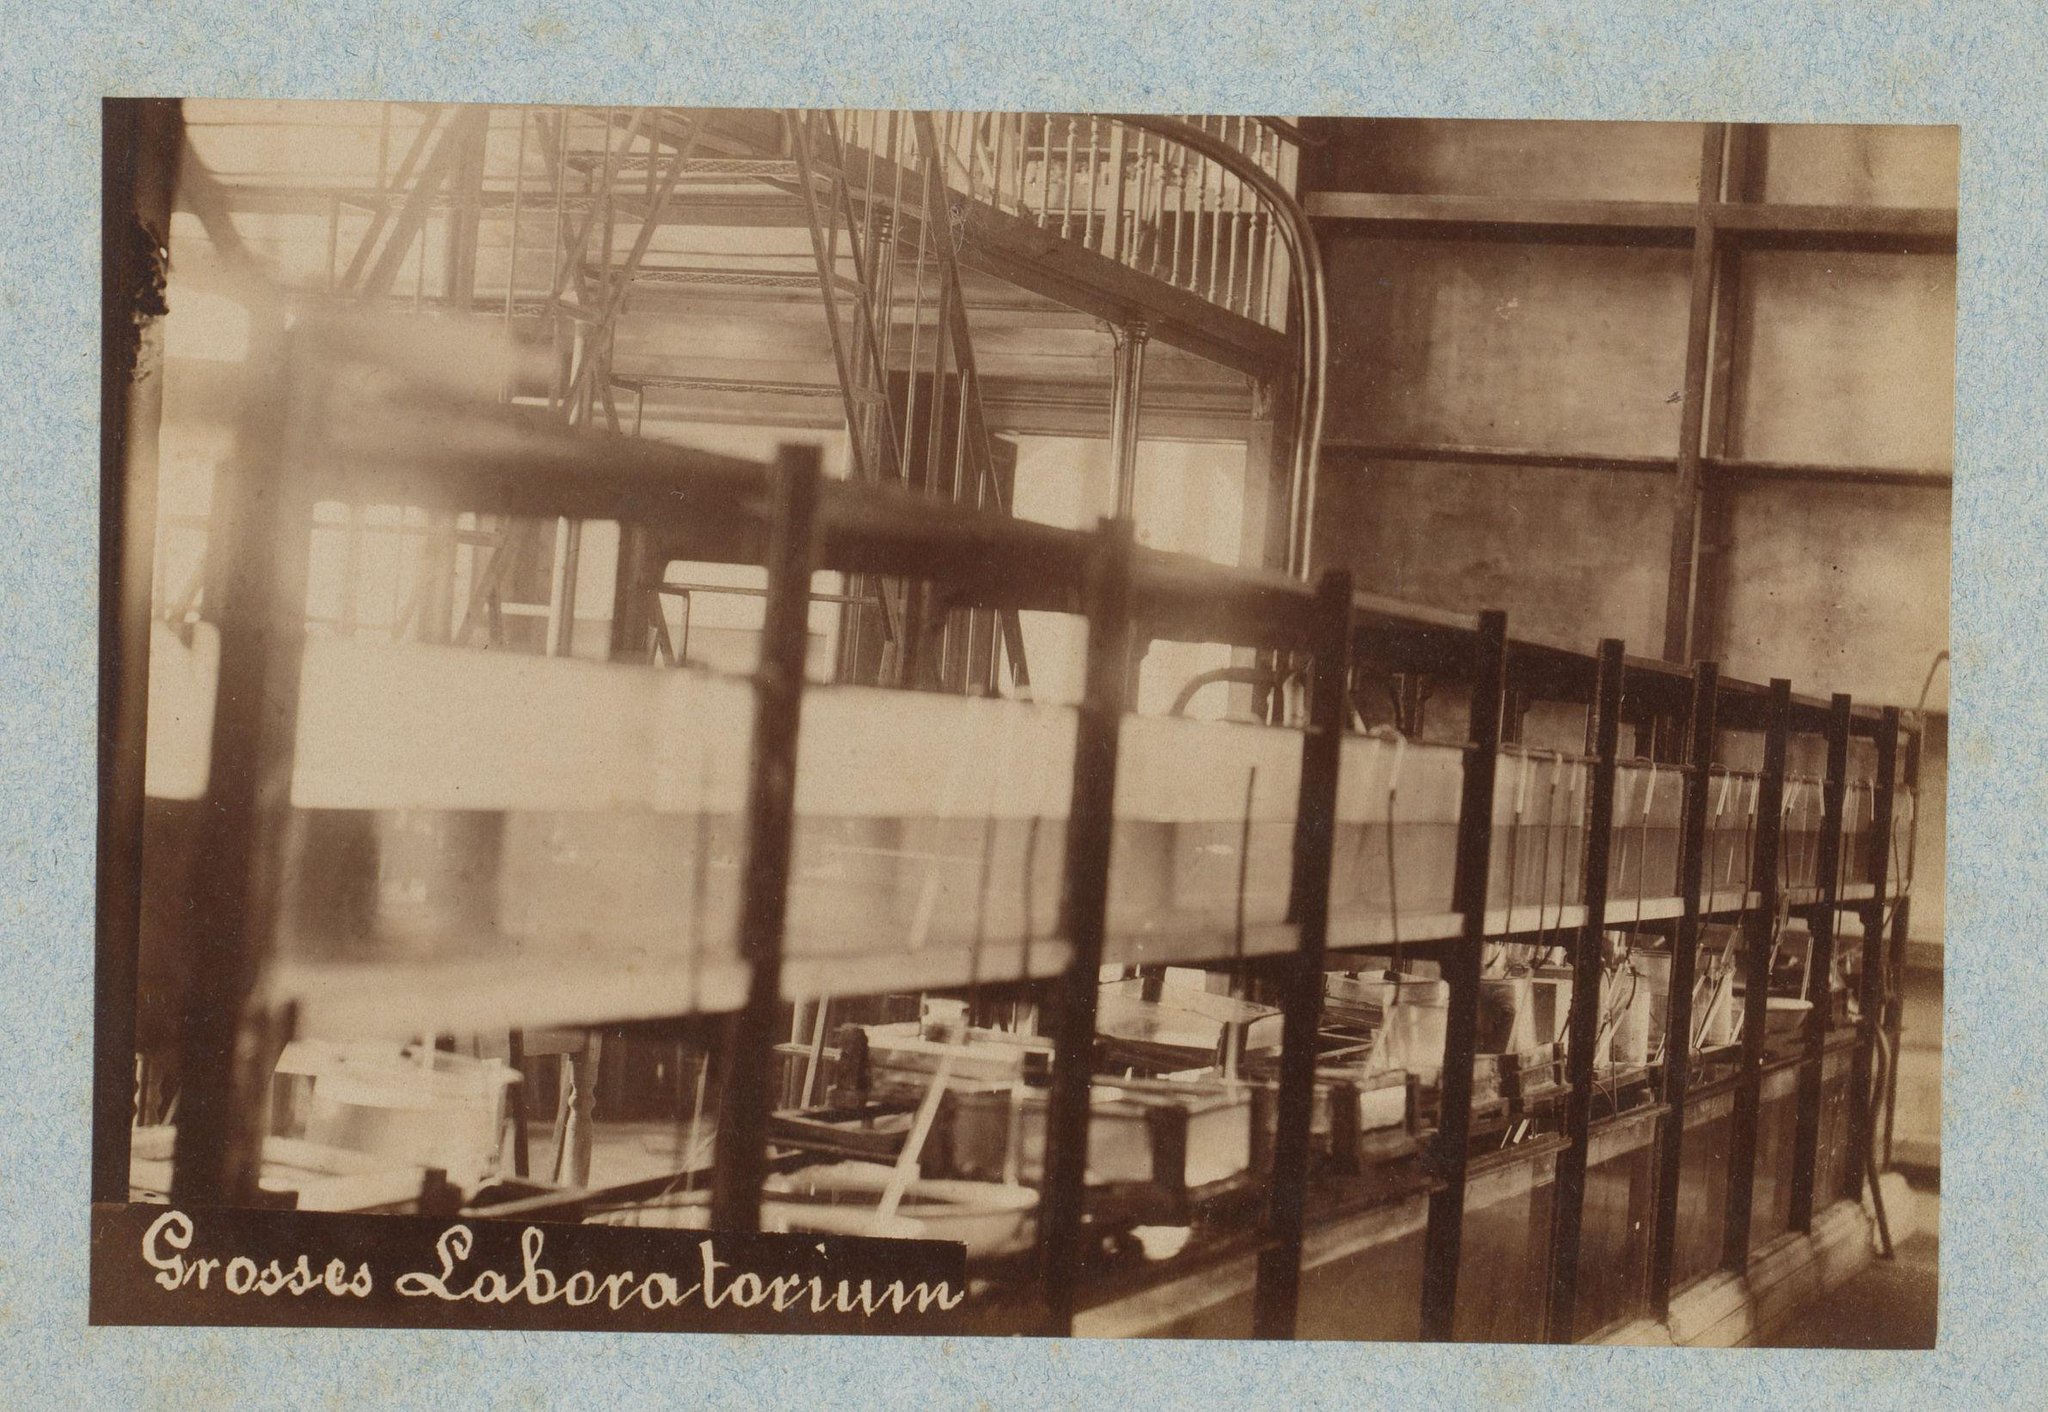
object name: photograph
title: Grosses Laboratorium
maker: Anonymous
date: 1874-1900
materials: cardboard, paper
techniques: albumen print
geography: naples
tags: laboratory (+ tools, instruments; laboratory equipment ~ scientific research)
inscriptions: collector's mark: ‘VOSMAER’